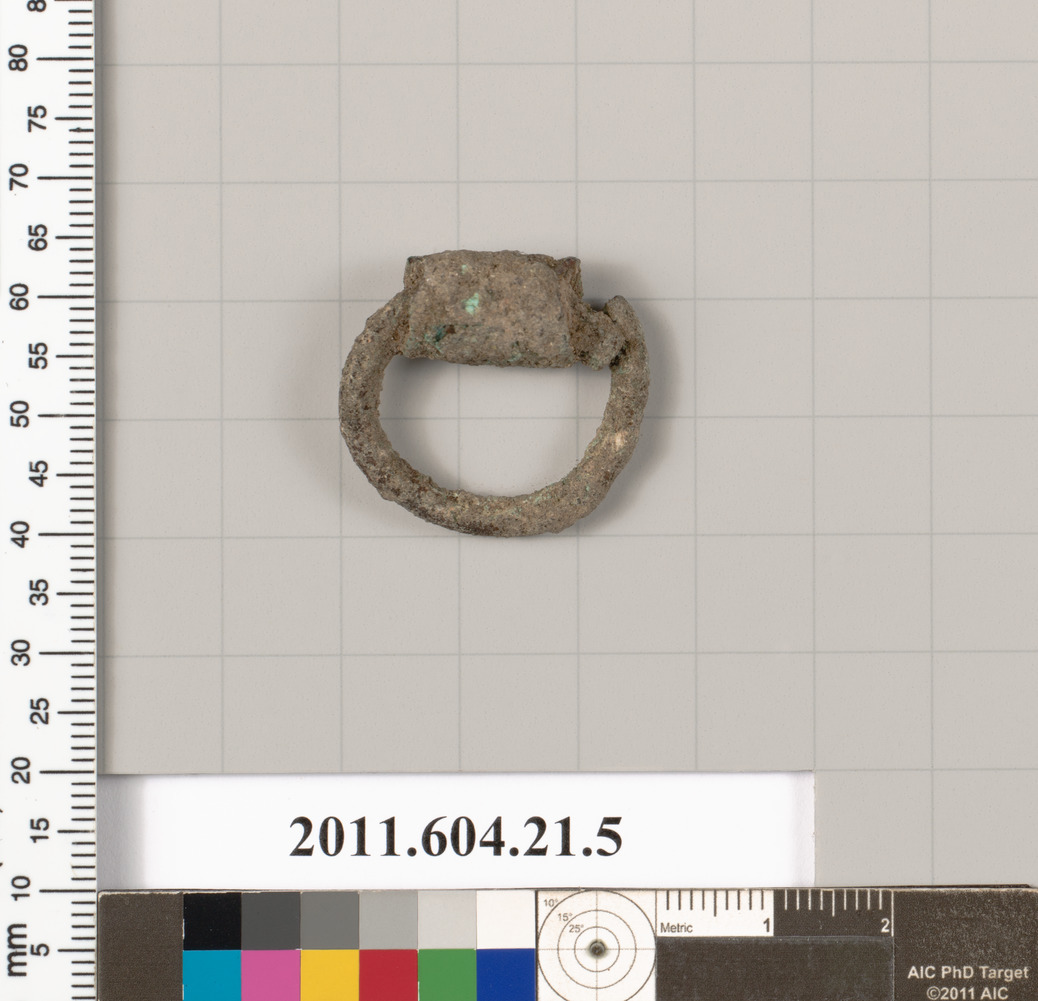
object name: bronze ring or pendant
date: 600-401 BCE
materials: bronze